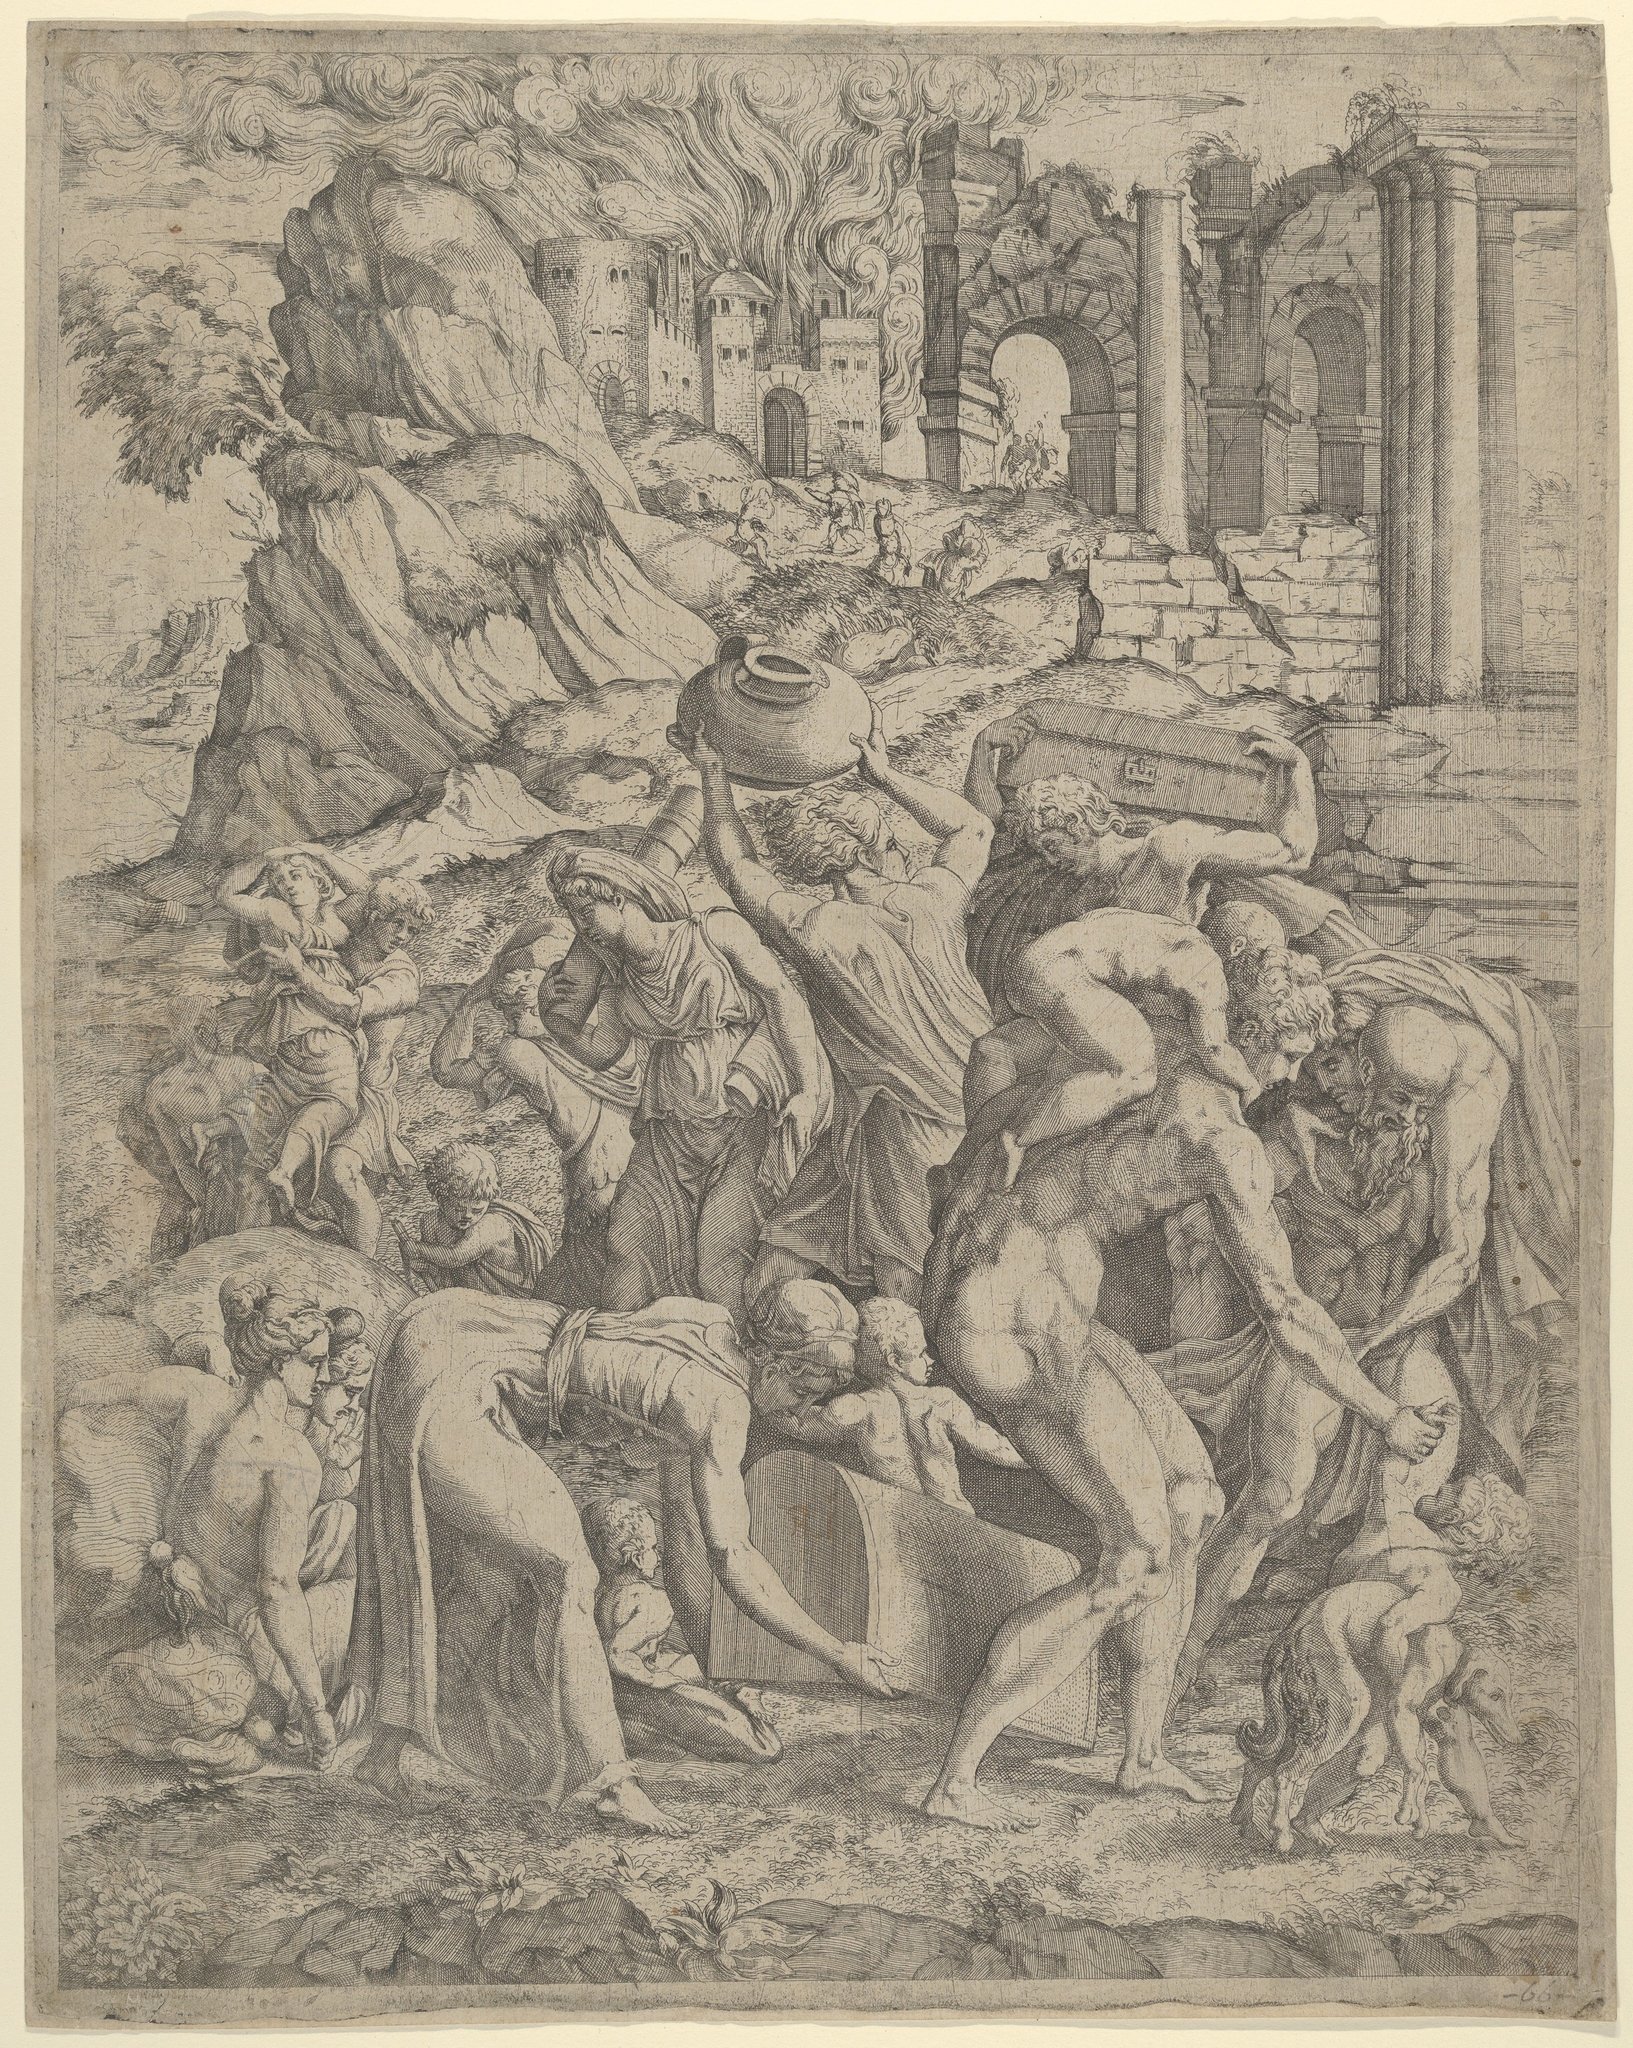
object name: print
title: People Fleeing a Burning City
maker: anonymous, french, school of fontainebleau, 16th century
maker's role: artist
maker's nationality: french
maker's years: 1500-1600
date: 1501-1600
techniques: etching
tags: children,men,women,dogs,fires